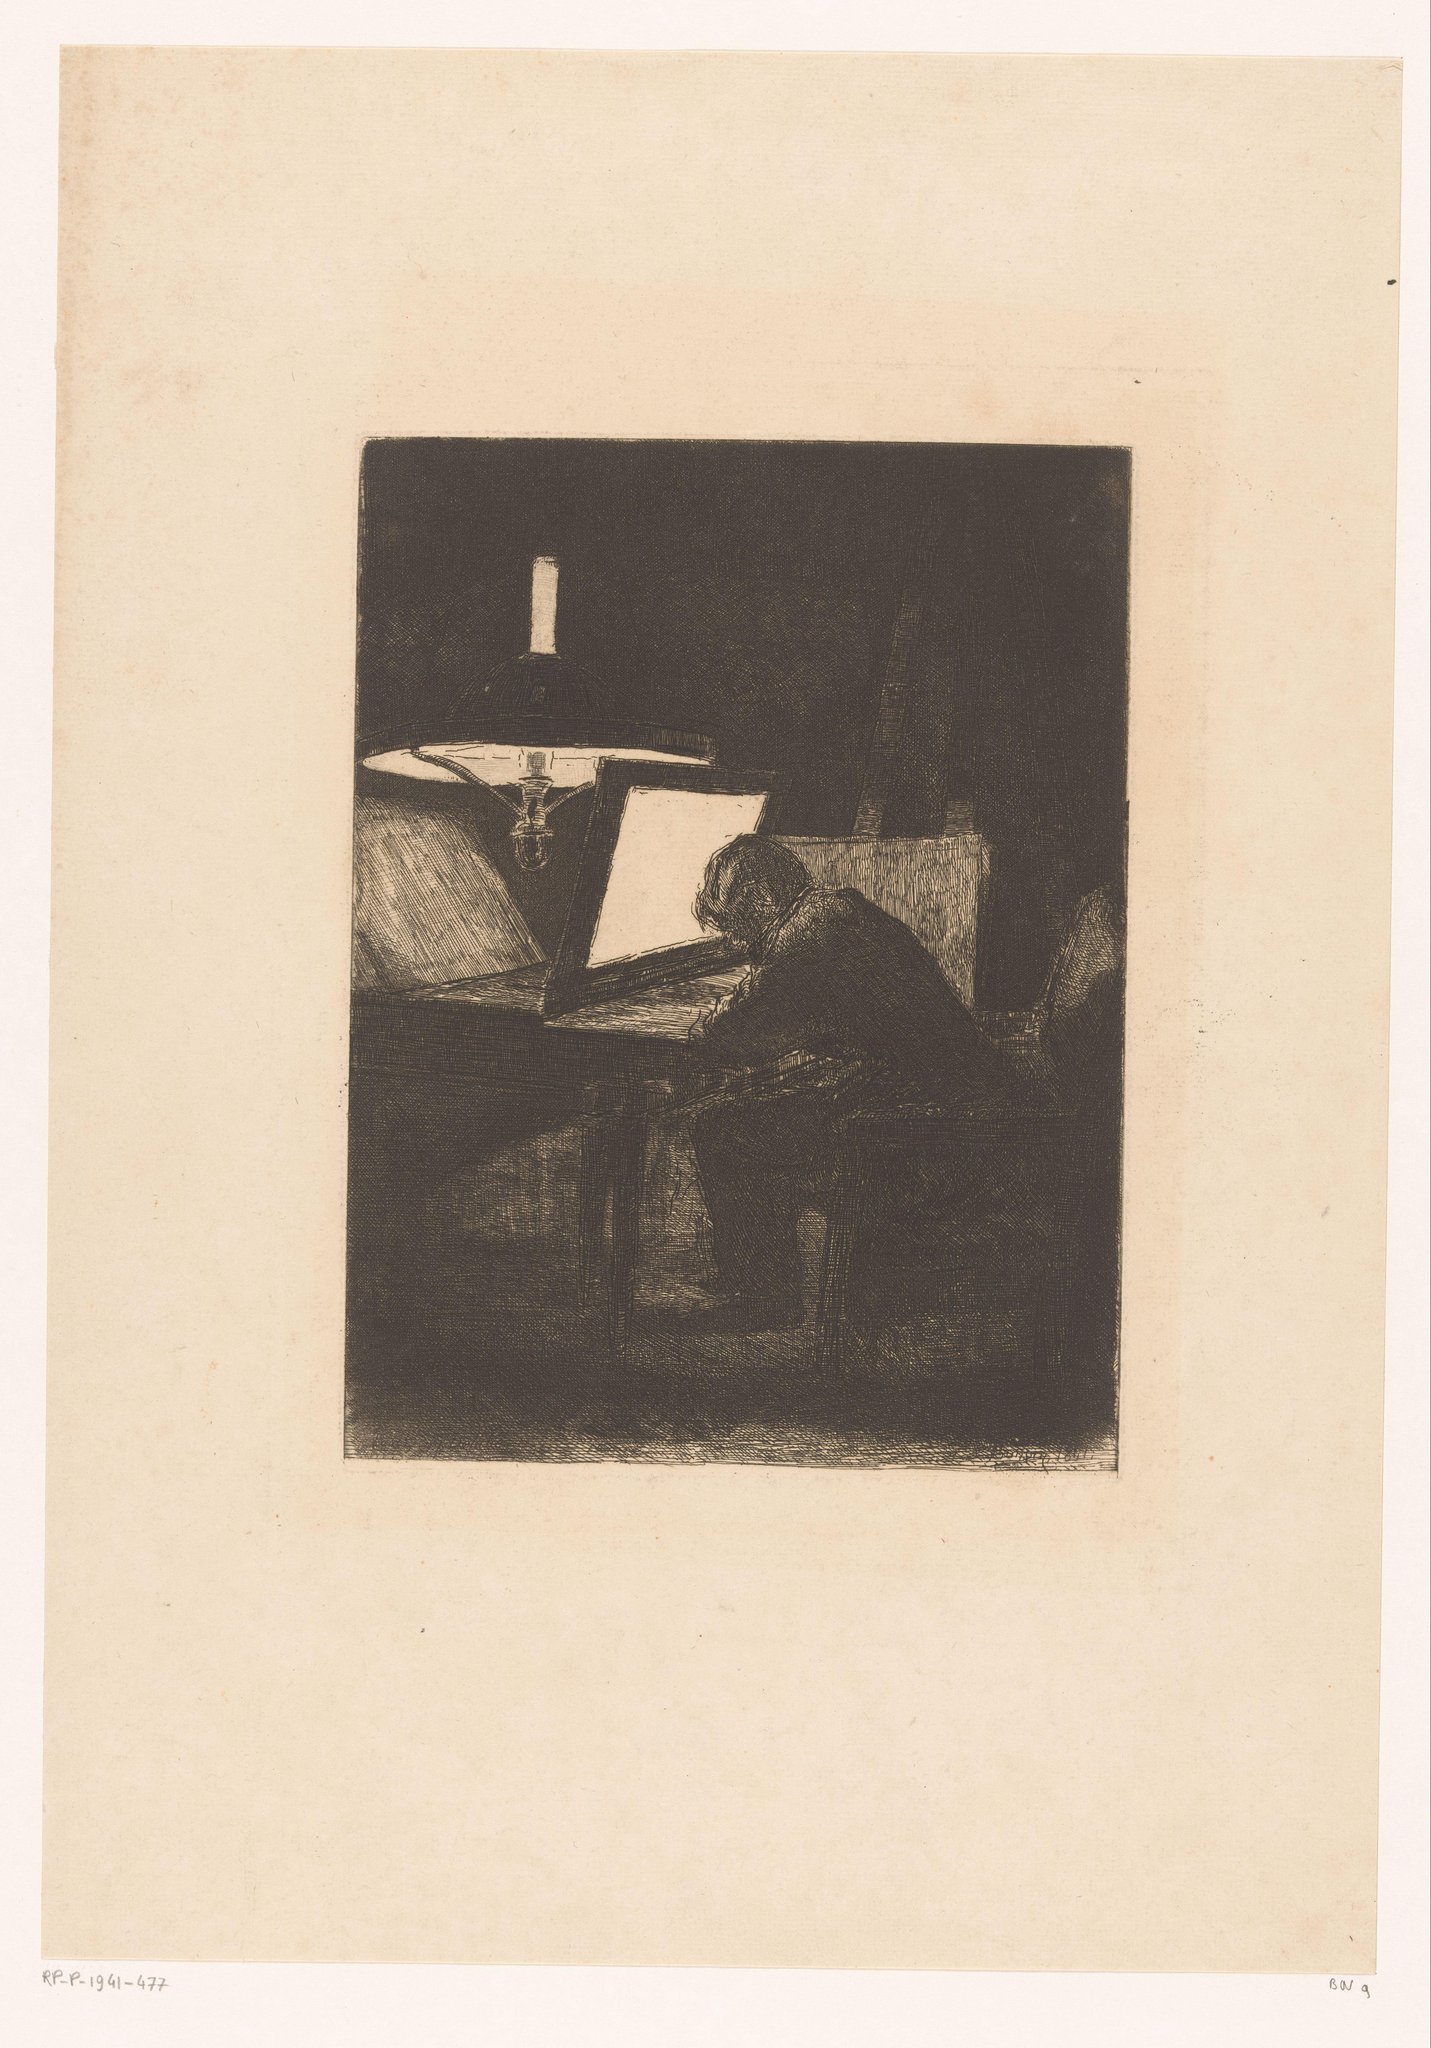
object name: print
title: Etser bij lamplicht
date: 1861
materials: paper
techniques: etching, intaglio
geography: paris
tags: engraver, etcher, artist at work, in his workshop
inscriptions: collector's mark: Lugt 2760, collector's mark: Lugt 2228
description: Maakt deel uit van een zesdelige serie, getiteld: Six Eaux-fortes, dessinées et gravées par F. Bonvin, Peintre. De eerste staat werd in 1861 door Bonvin uitgegeven in Parijs.